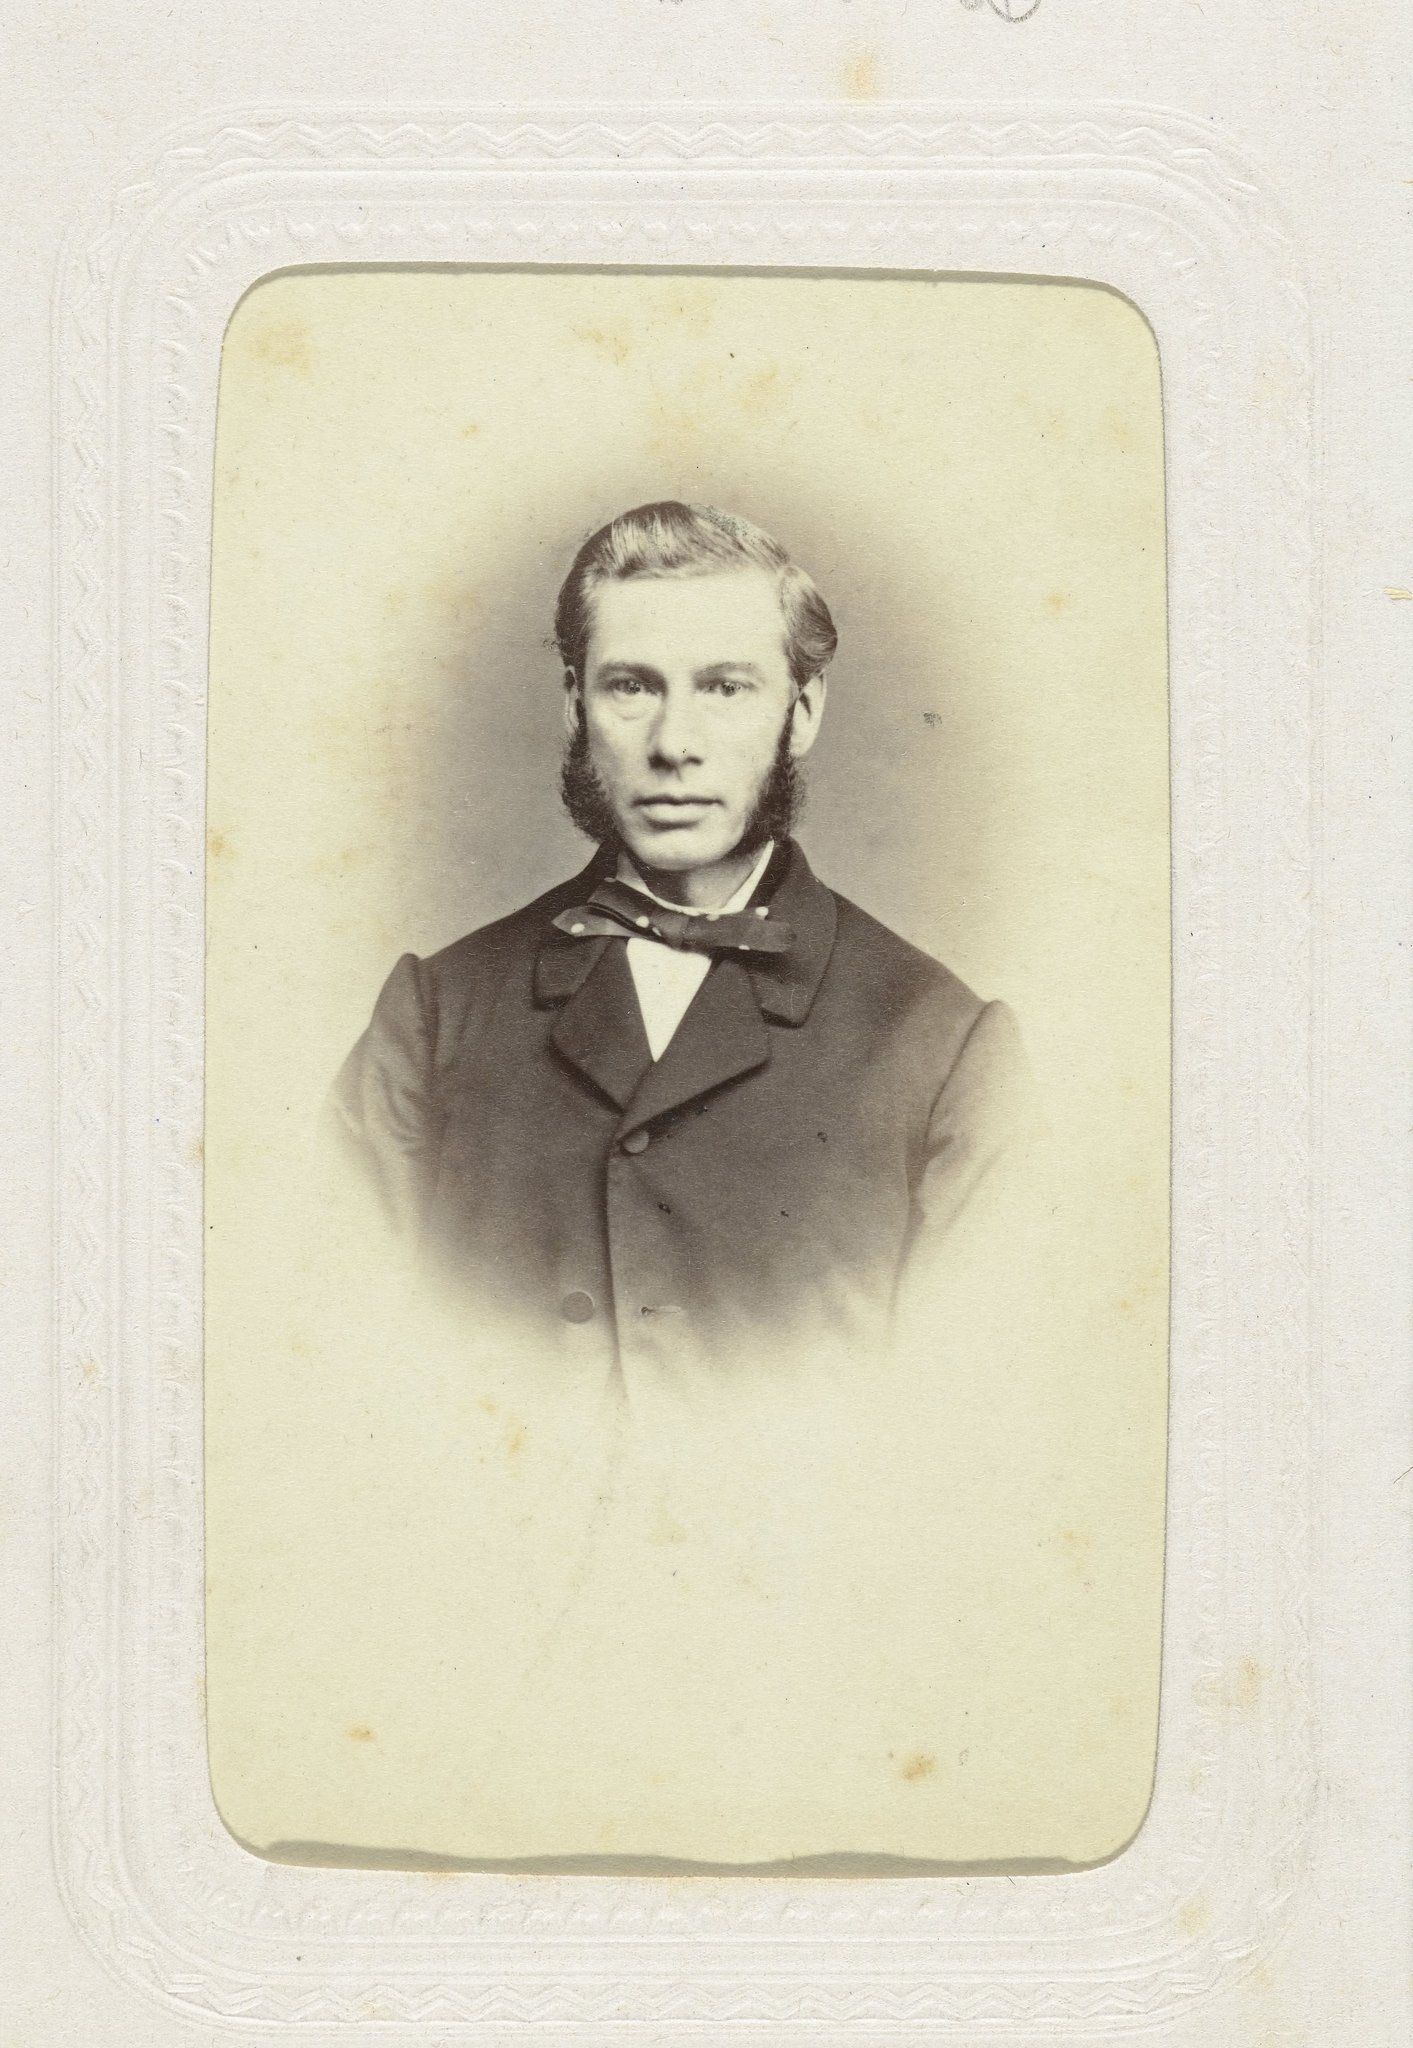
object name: carte de visite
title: Studioportret van een man met met grote bakkebaarden en een vlinderdas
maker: louis robert werner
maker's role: fotograaf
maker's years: 1834-1896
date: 1863-1866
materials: cardboard, paper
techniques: albumen print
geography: amsterdam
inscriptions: title: ‘A.W.M. van Hasselt’